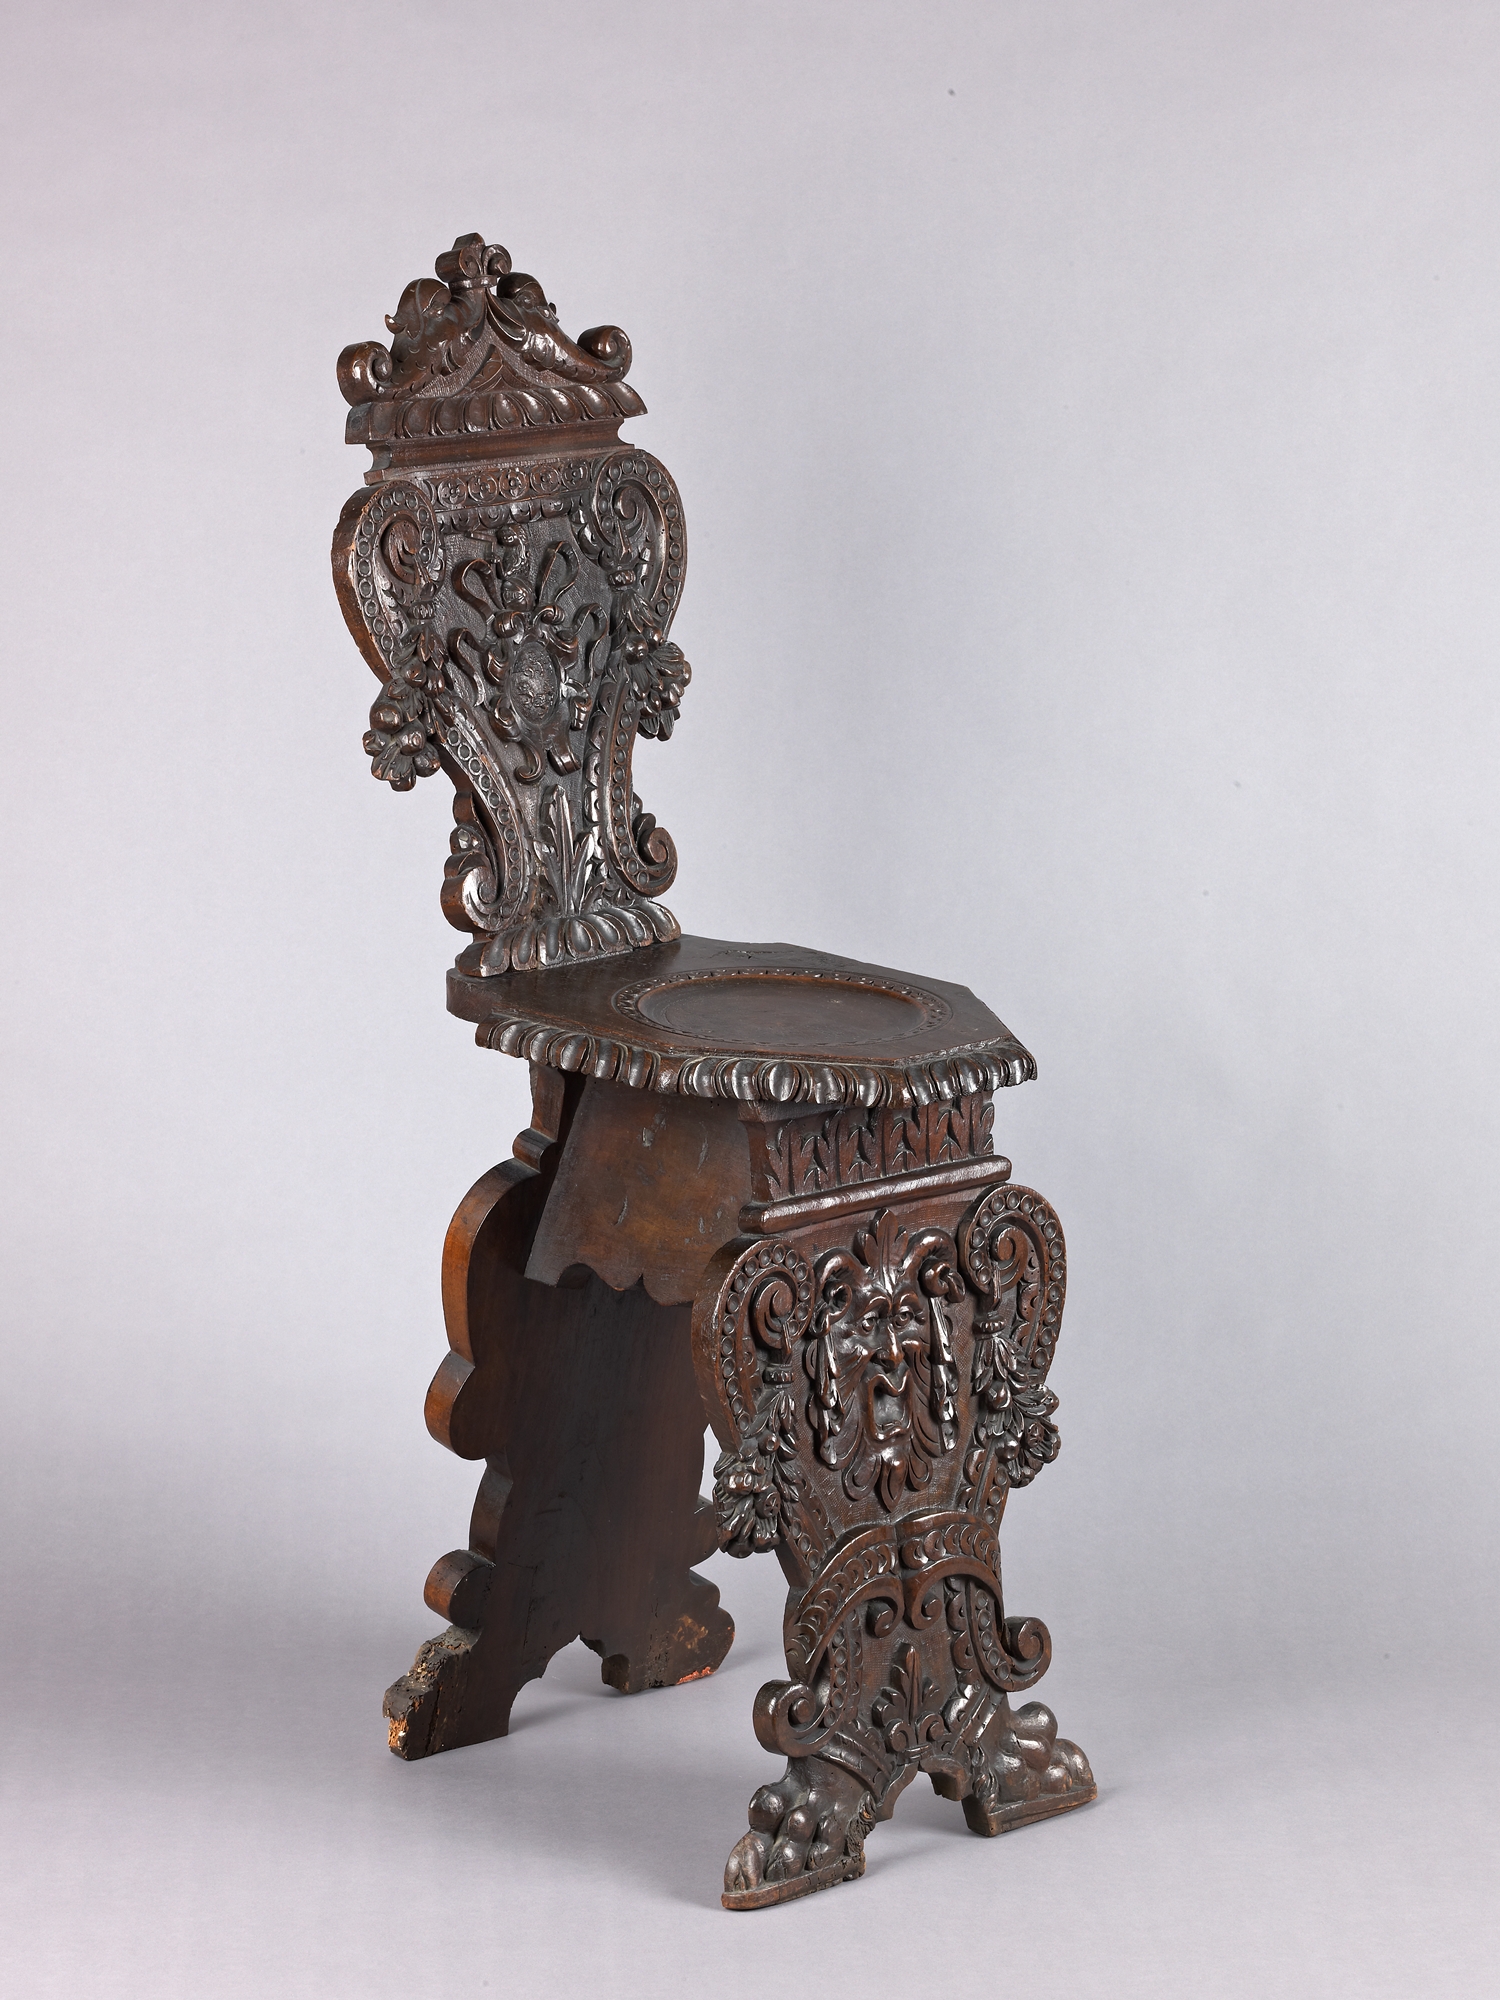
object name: chair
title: Side chair (Sgabello, pair with 1975.1.1990)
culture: italian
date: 1567-1600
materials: wood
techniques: carving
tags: masks